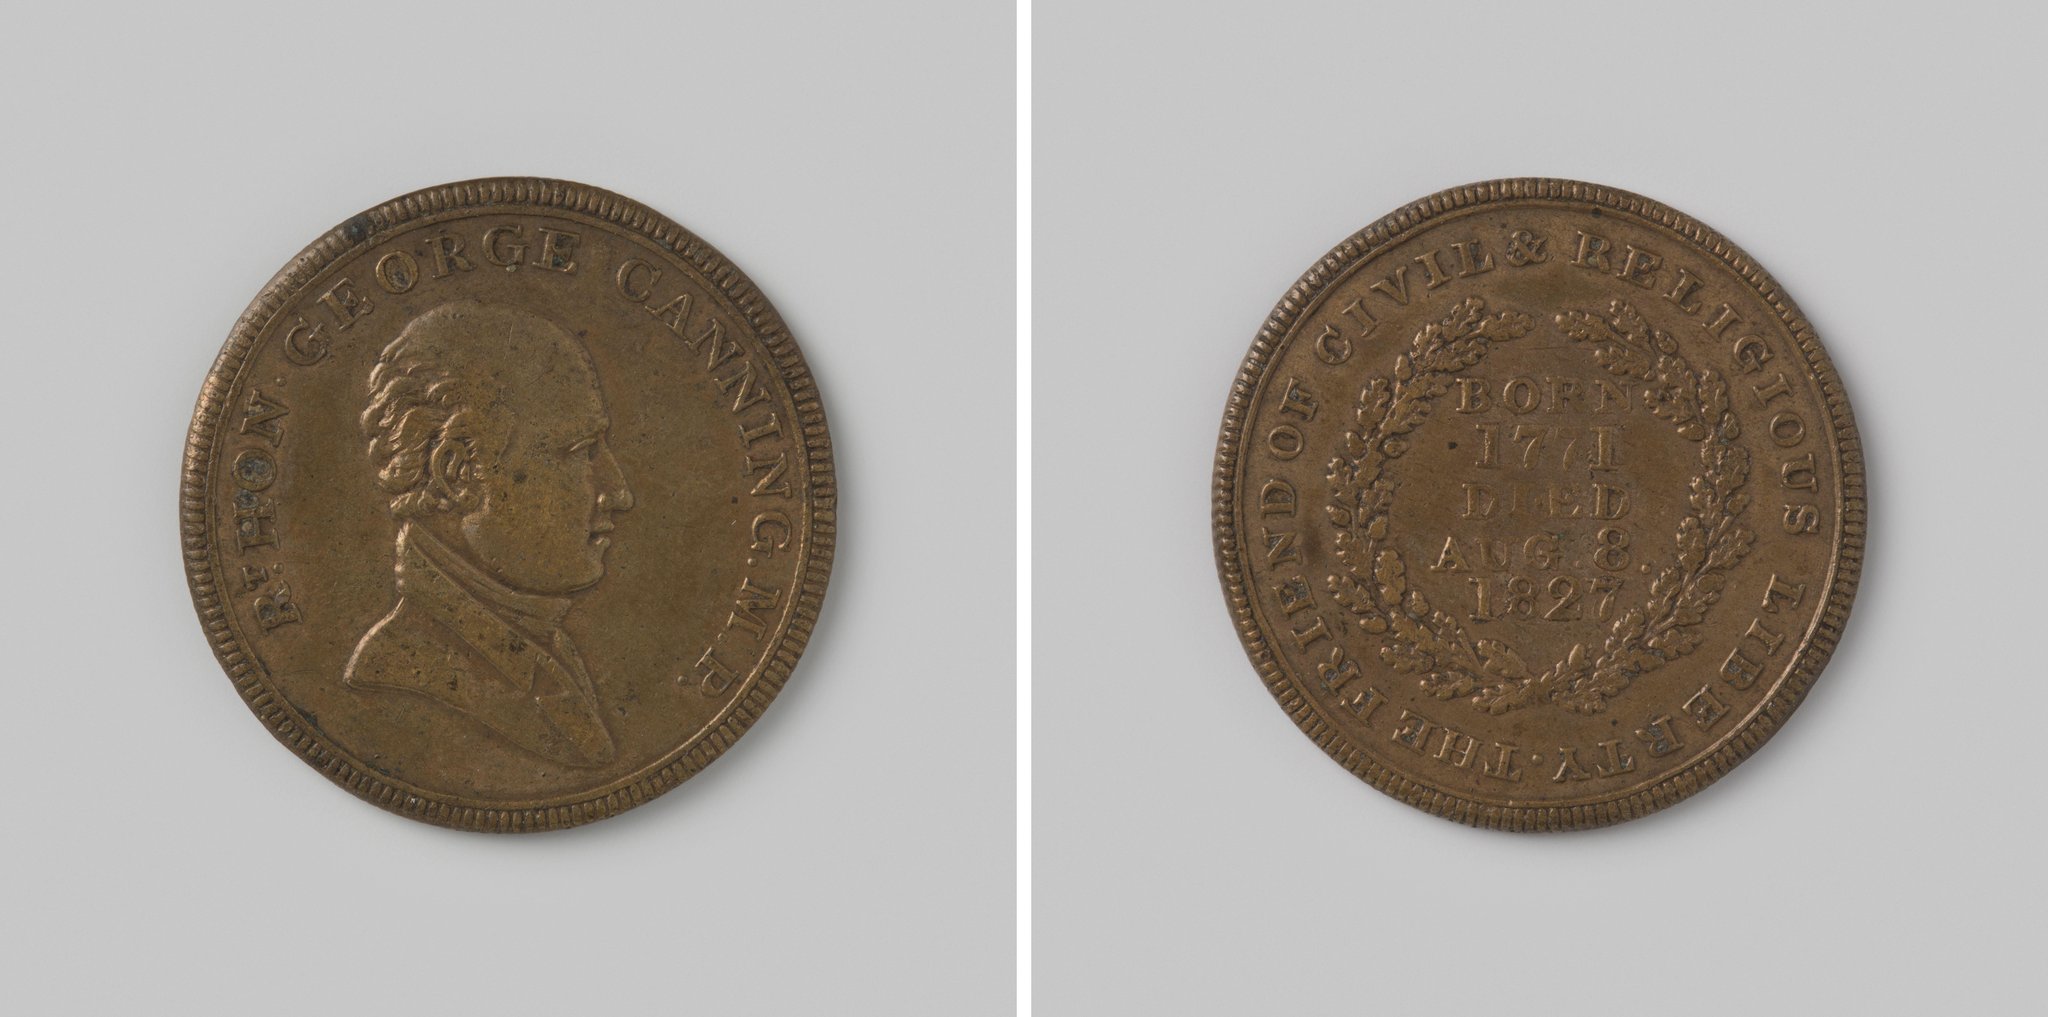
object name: history medal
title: Overlijden van George Canning 1827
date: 1827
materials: brass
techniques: striking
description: Messing penning, op de voorzijde het borstbeeld van Canning naar rechts met omschrift, op de keerzijde vijf regels tekst tussen eikentakken, met omschrift, met kartelrand.